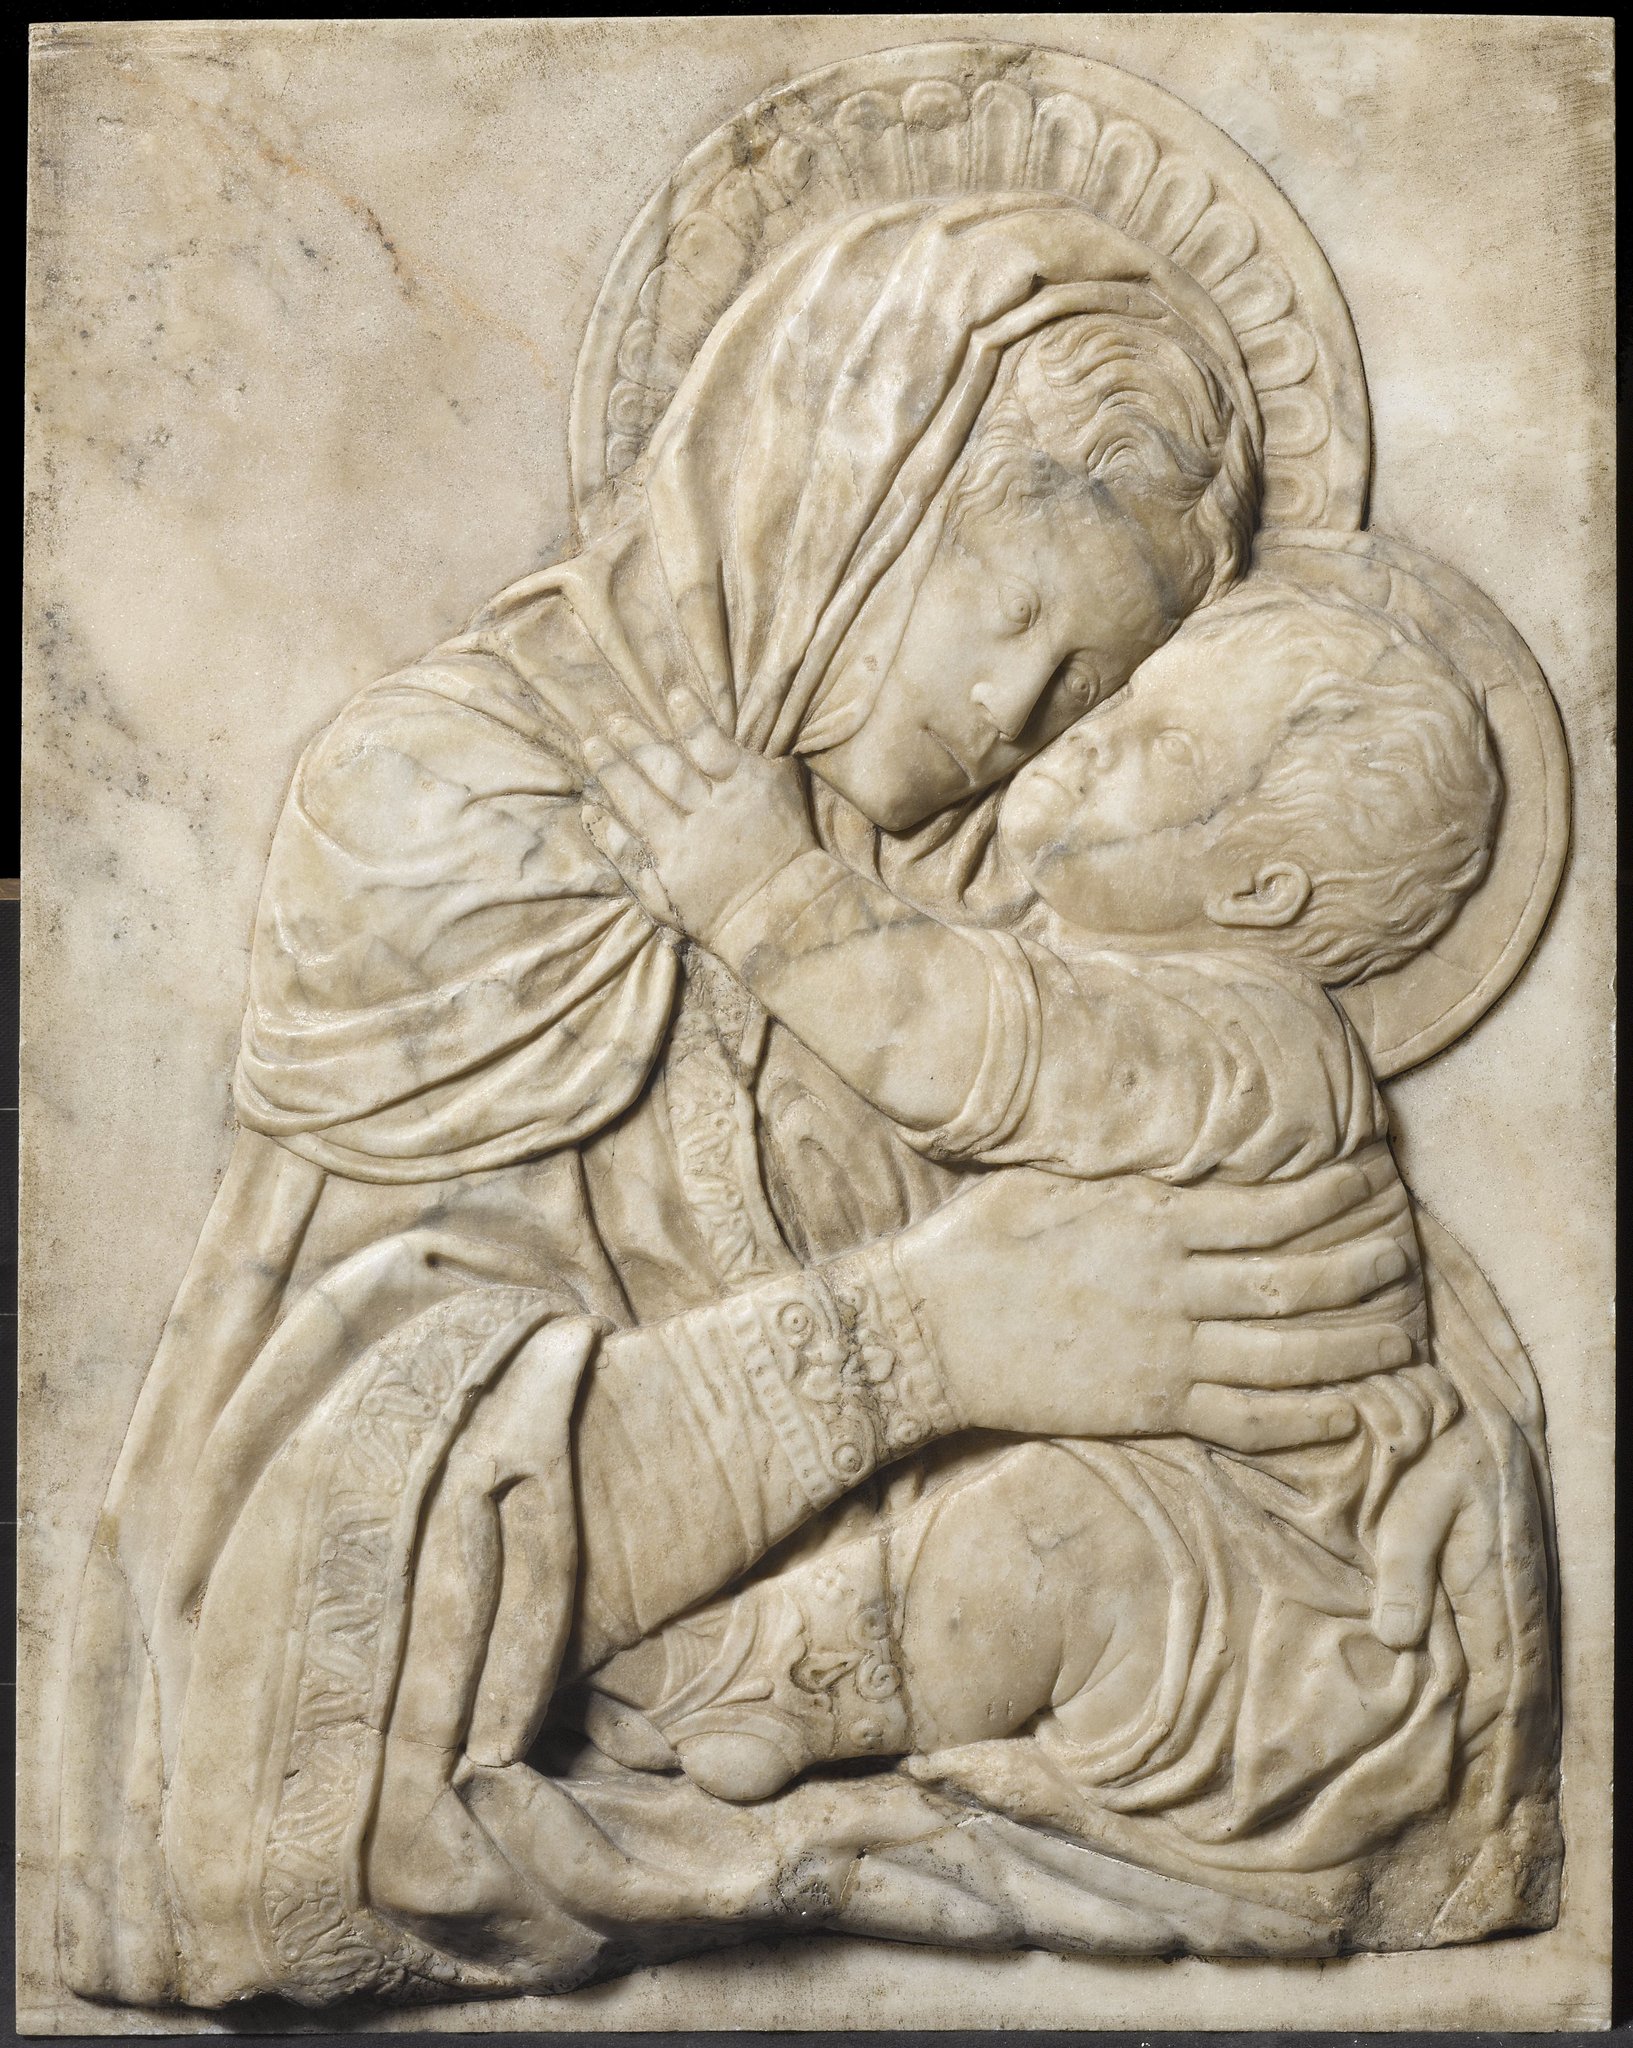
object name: sculpture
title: Maria met kind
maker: bartolomeo bellano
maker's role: sculptor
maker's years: 1437-1497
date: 1475-1500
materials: marble